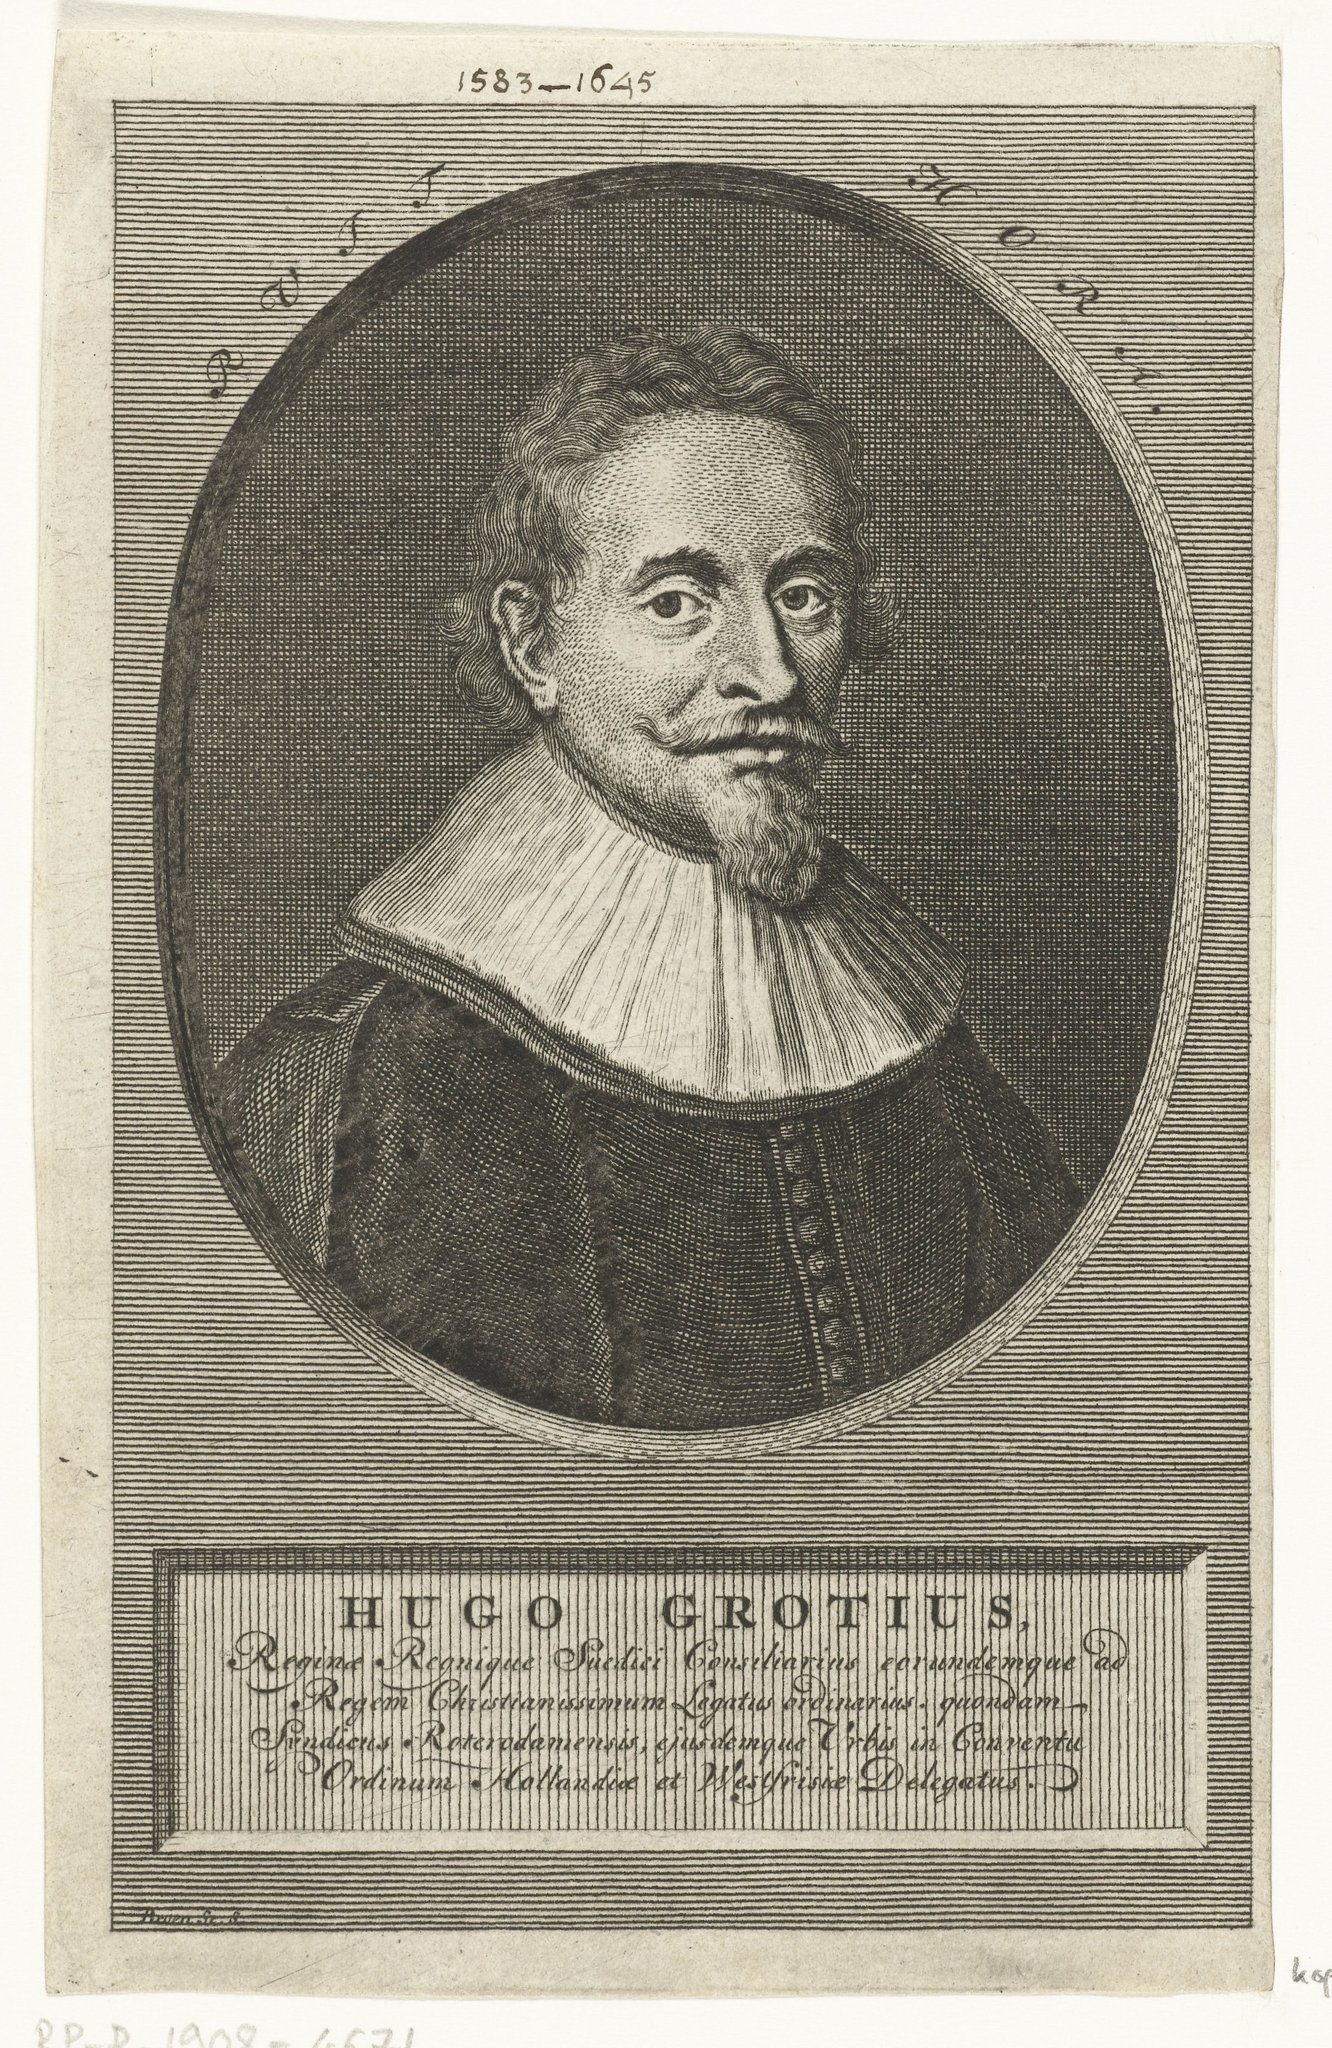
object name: print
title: Portret van Hugo de Groot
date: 1705-1798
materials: paper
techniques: engraving, etching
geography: amsterdam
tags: delft, hugo de groot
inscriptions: collector's mark: Lugt 2228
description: Borstbeeld van Hugo de Groot in ovaal met motto. Onder het portret zijn naam en titels.